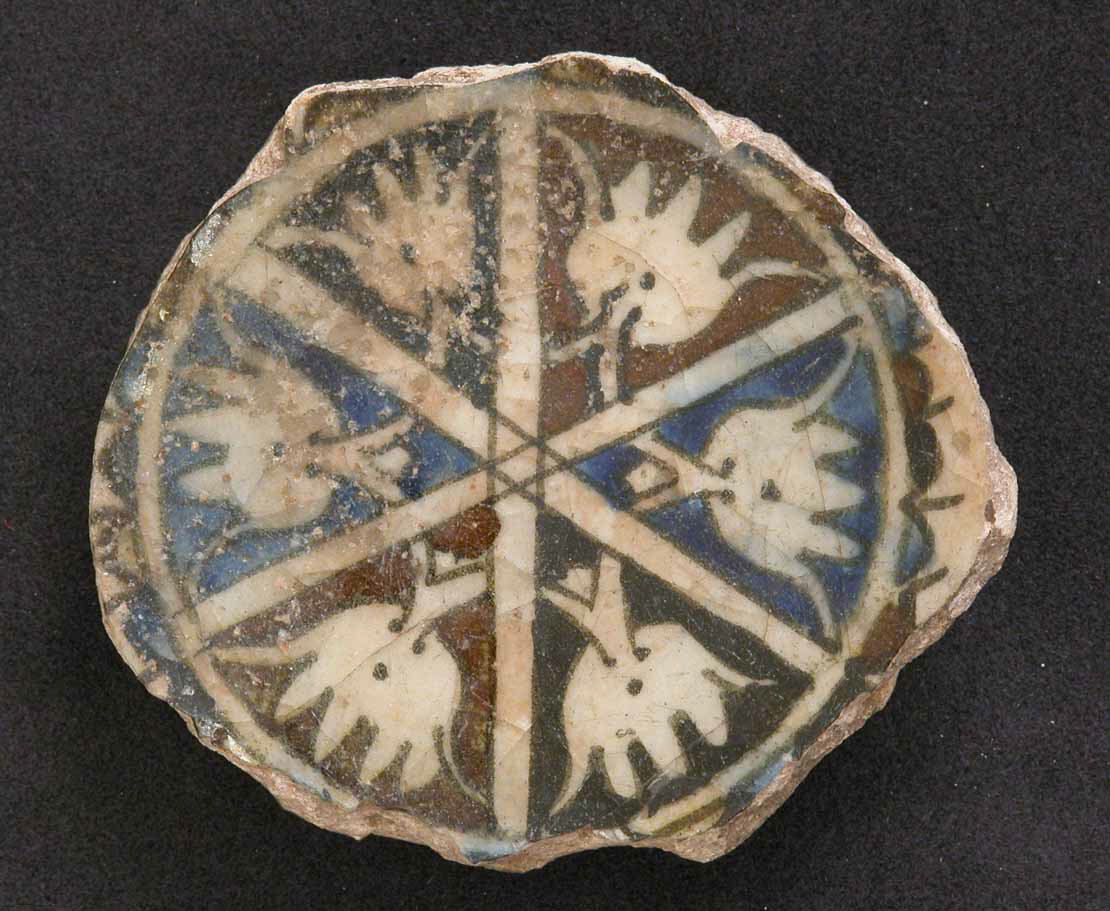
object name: fragment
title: Fragment of a Bowl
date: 1201-1300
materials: stonepaste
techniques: painting, underglaze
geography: syria